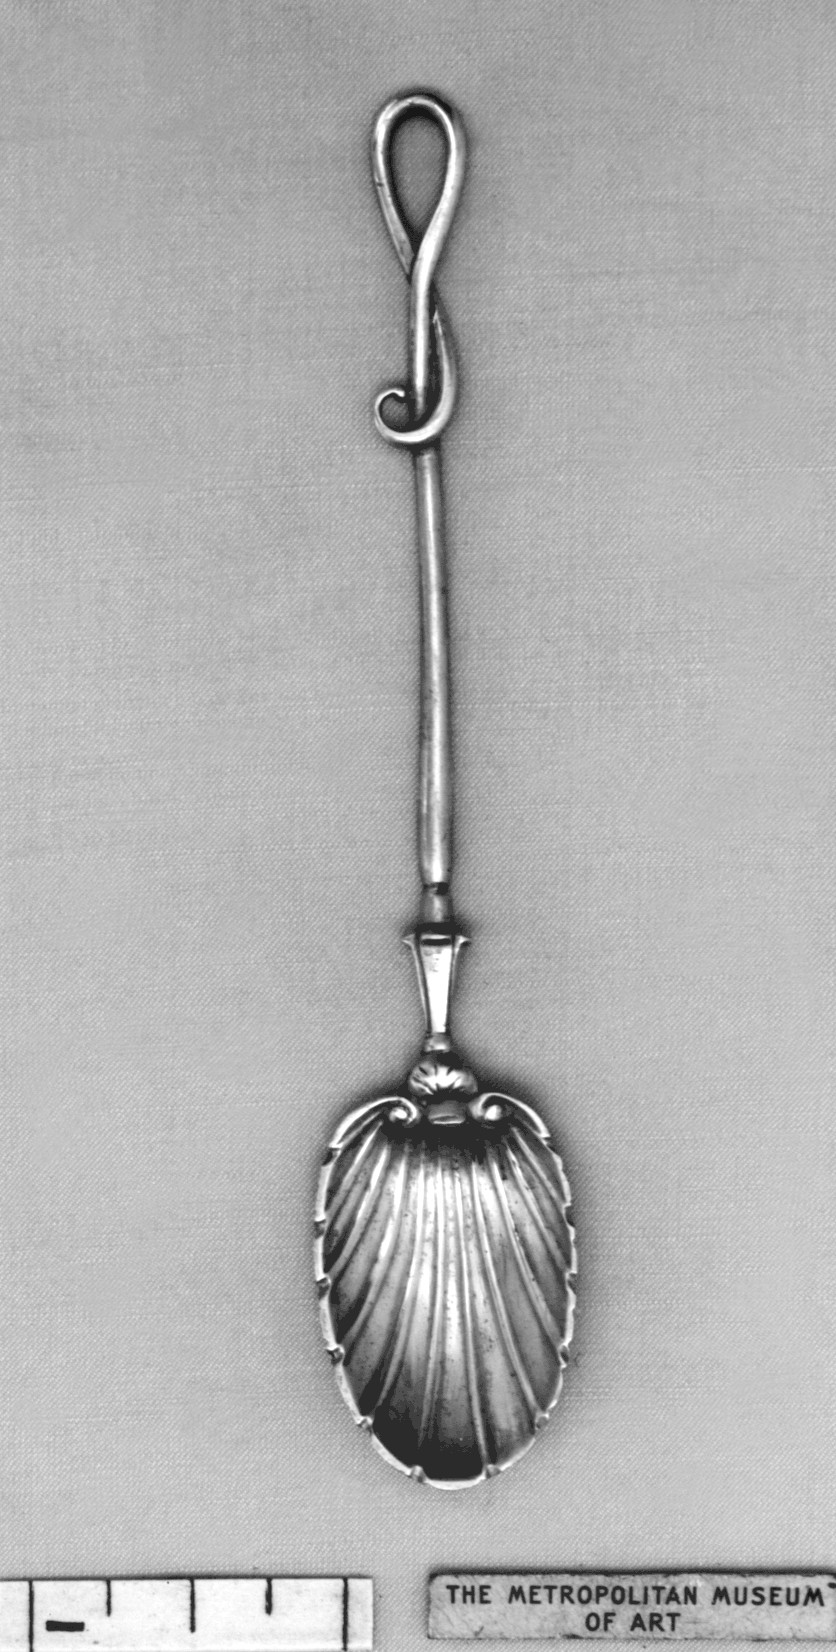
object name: salt spoon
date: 1801-1900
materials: silver